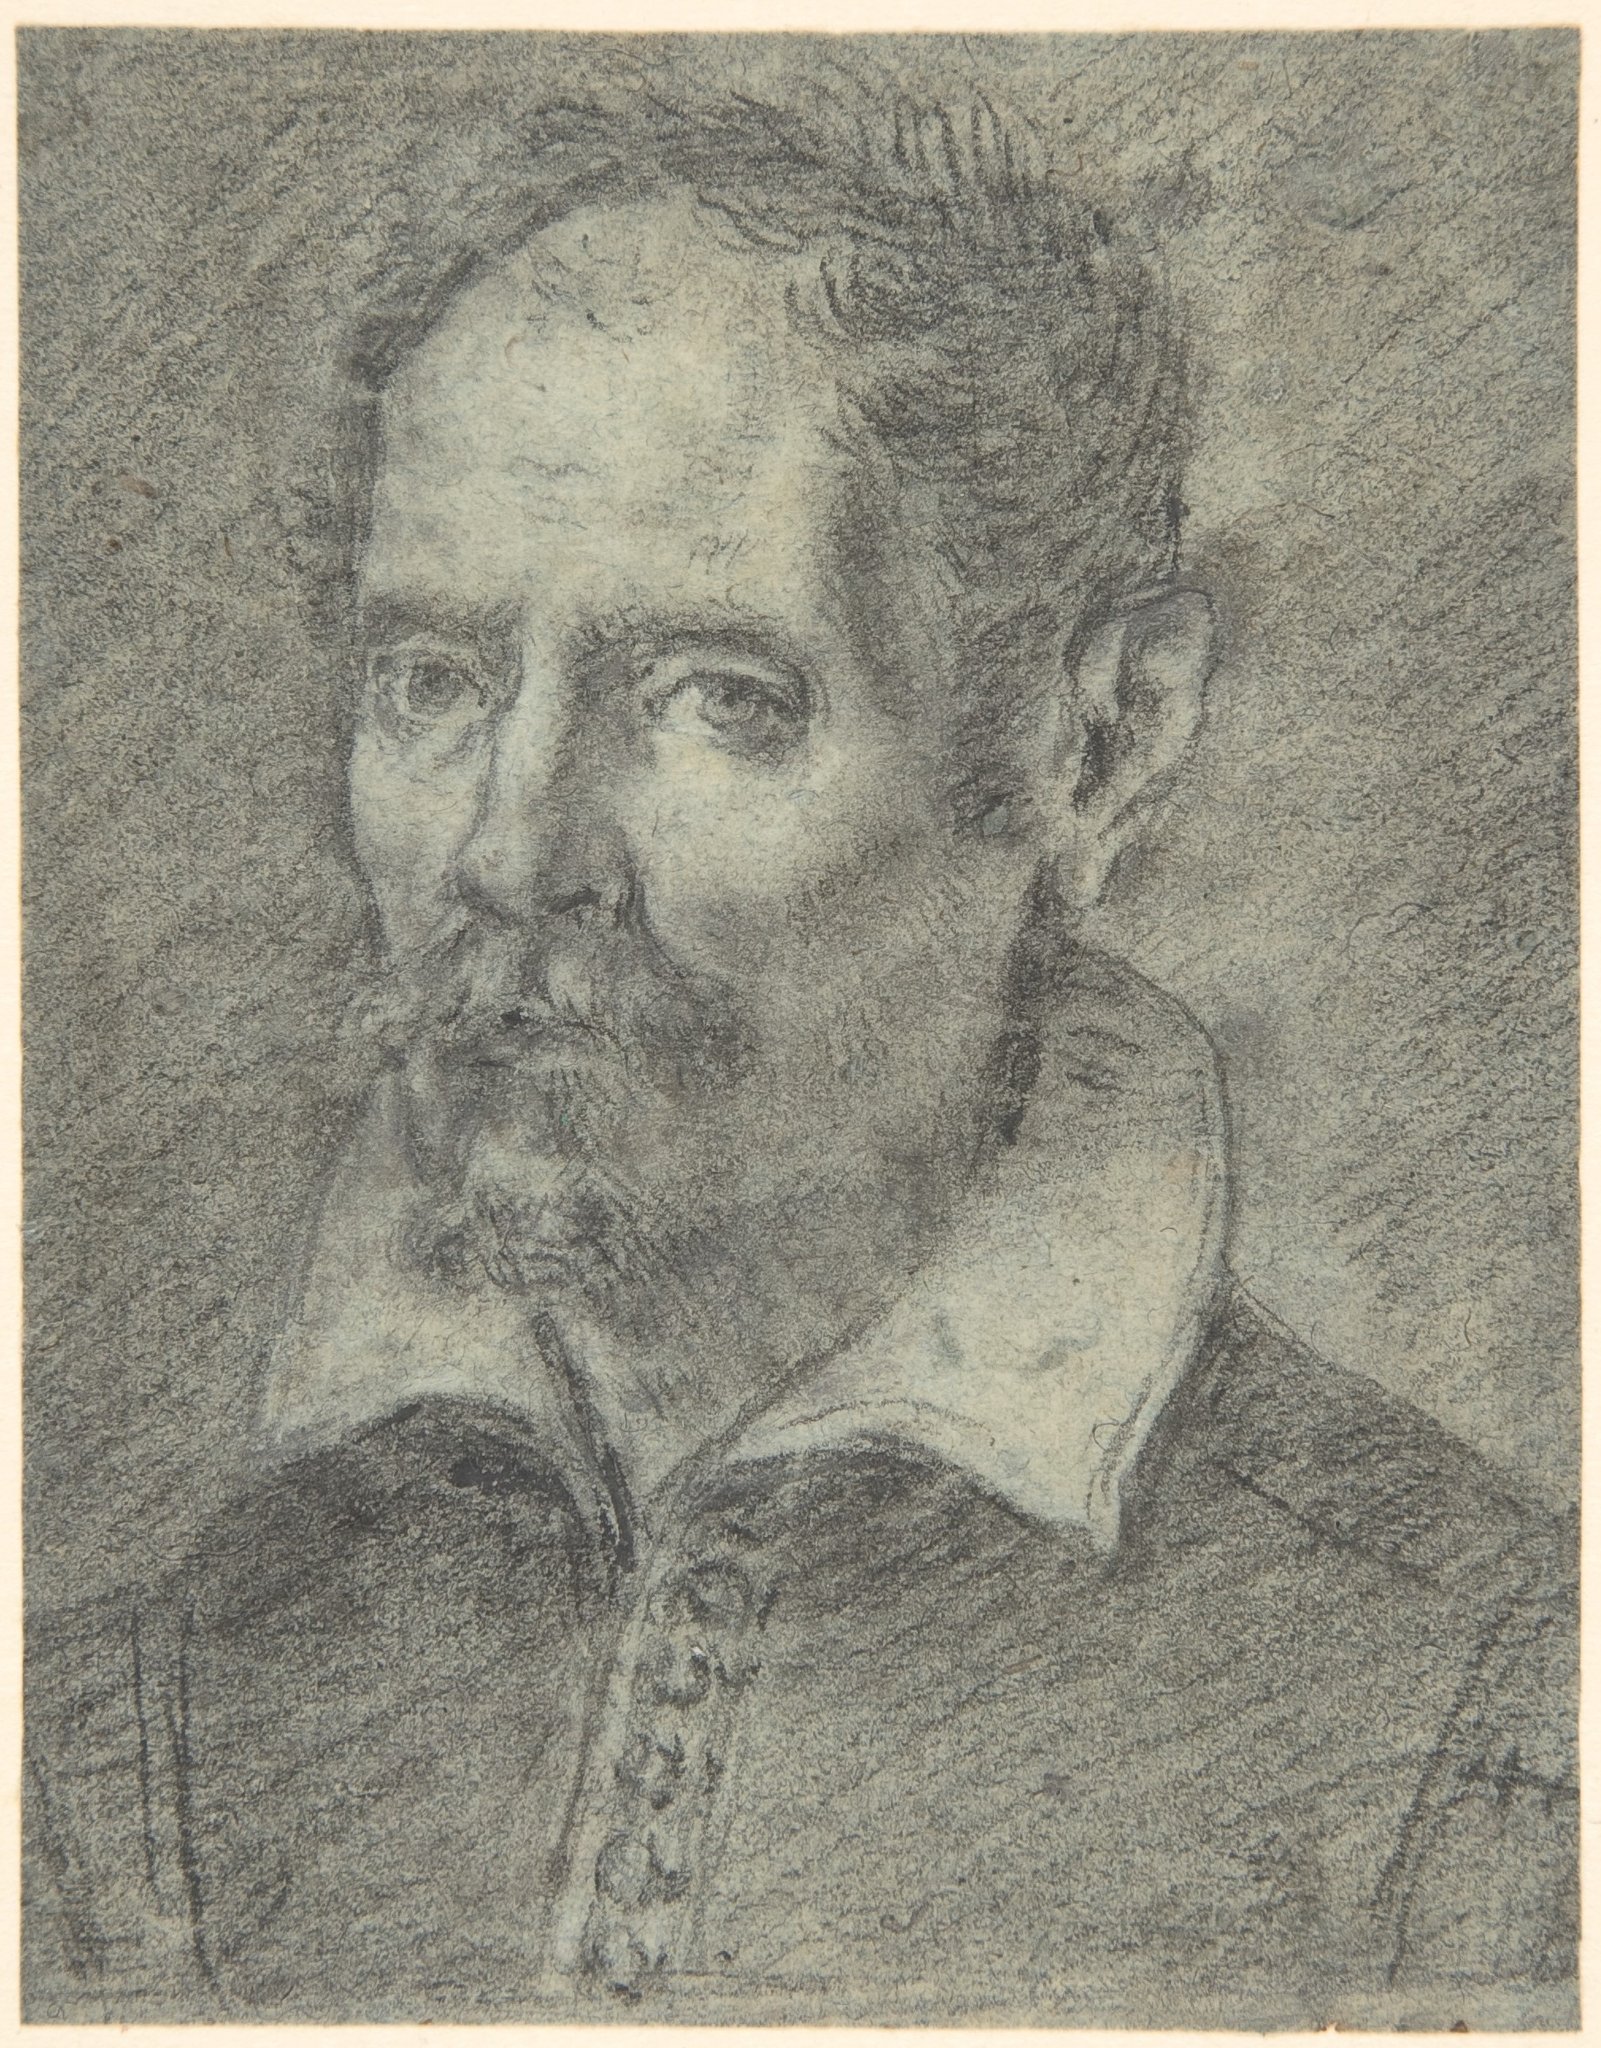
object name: drawing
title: Head of a Bearded Man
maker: francisco pacheco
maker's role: artist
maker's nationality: spanish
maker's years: 1564-1644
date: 1564-1644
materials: chalk, paper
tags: heads,men,portraits